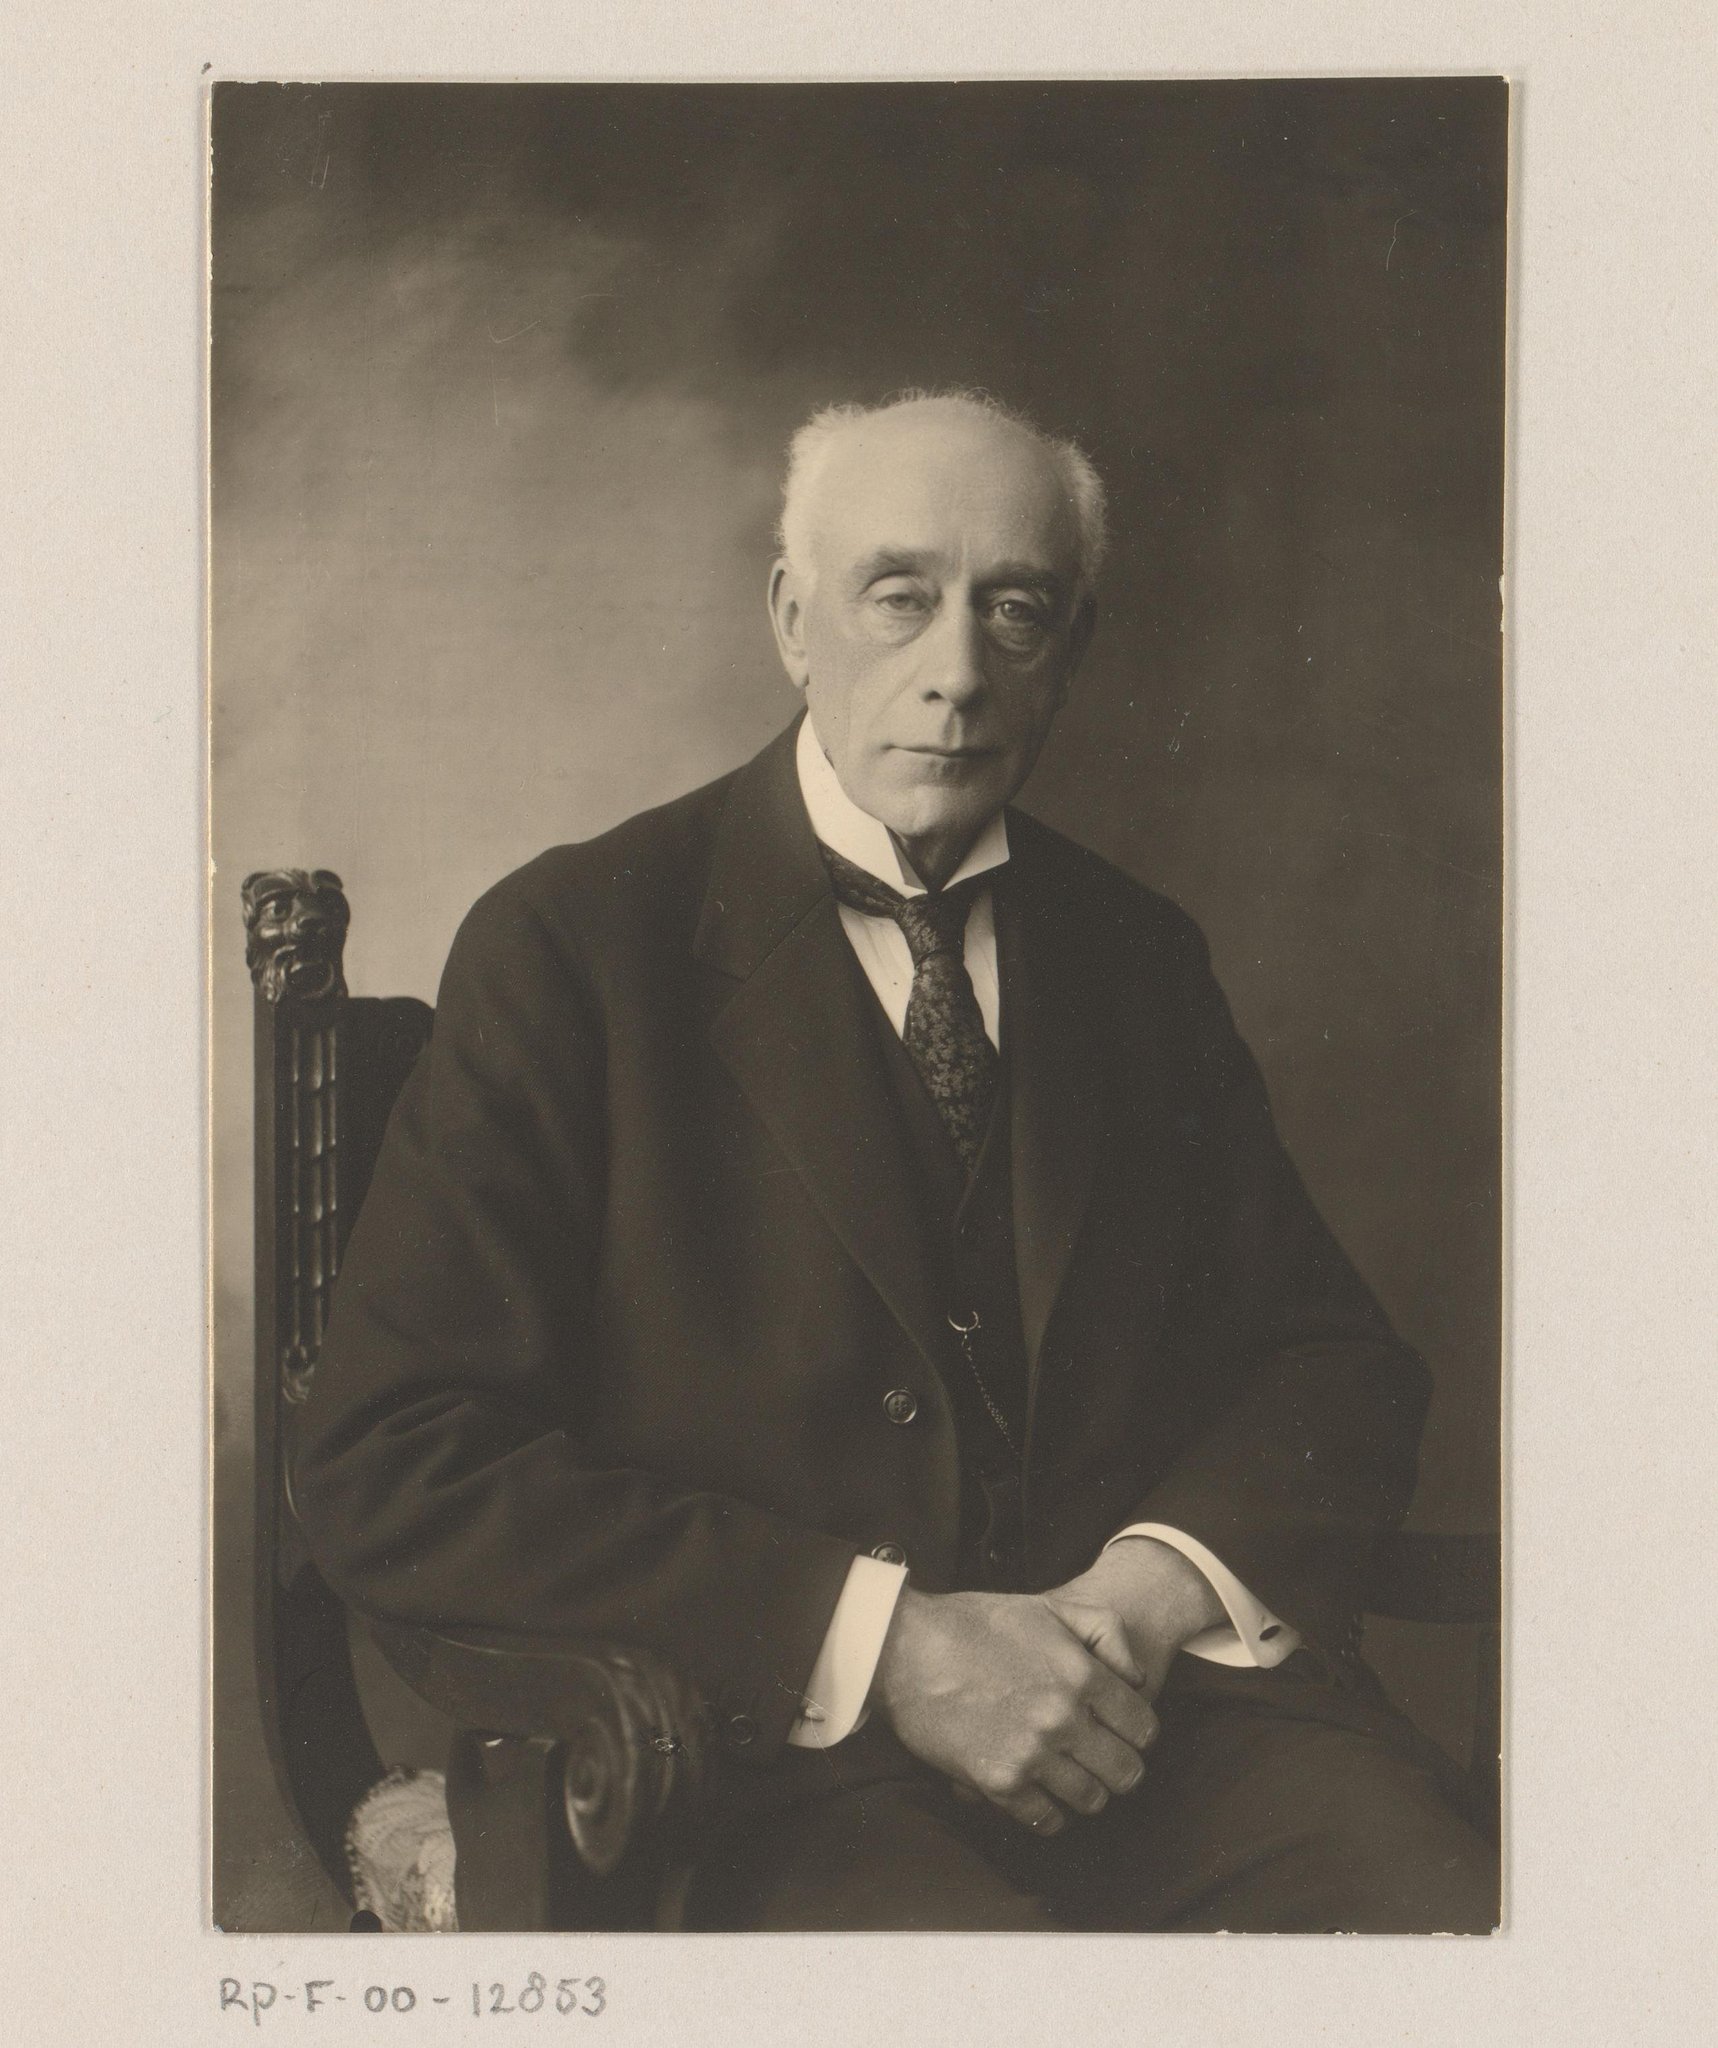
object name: photograph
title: Portret van Hendrik Pieter Marchant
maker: Anonymous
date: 1930-1956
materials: paper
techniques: gelatin silver print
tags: politician, historical persons, politician, e.g. party leader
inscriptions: inscription: ‘Mr M P Marchant/ minister v Onderwijs’